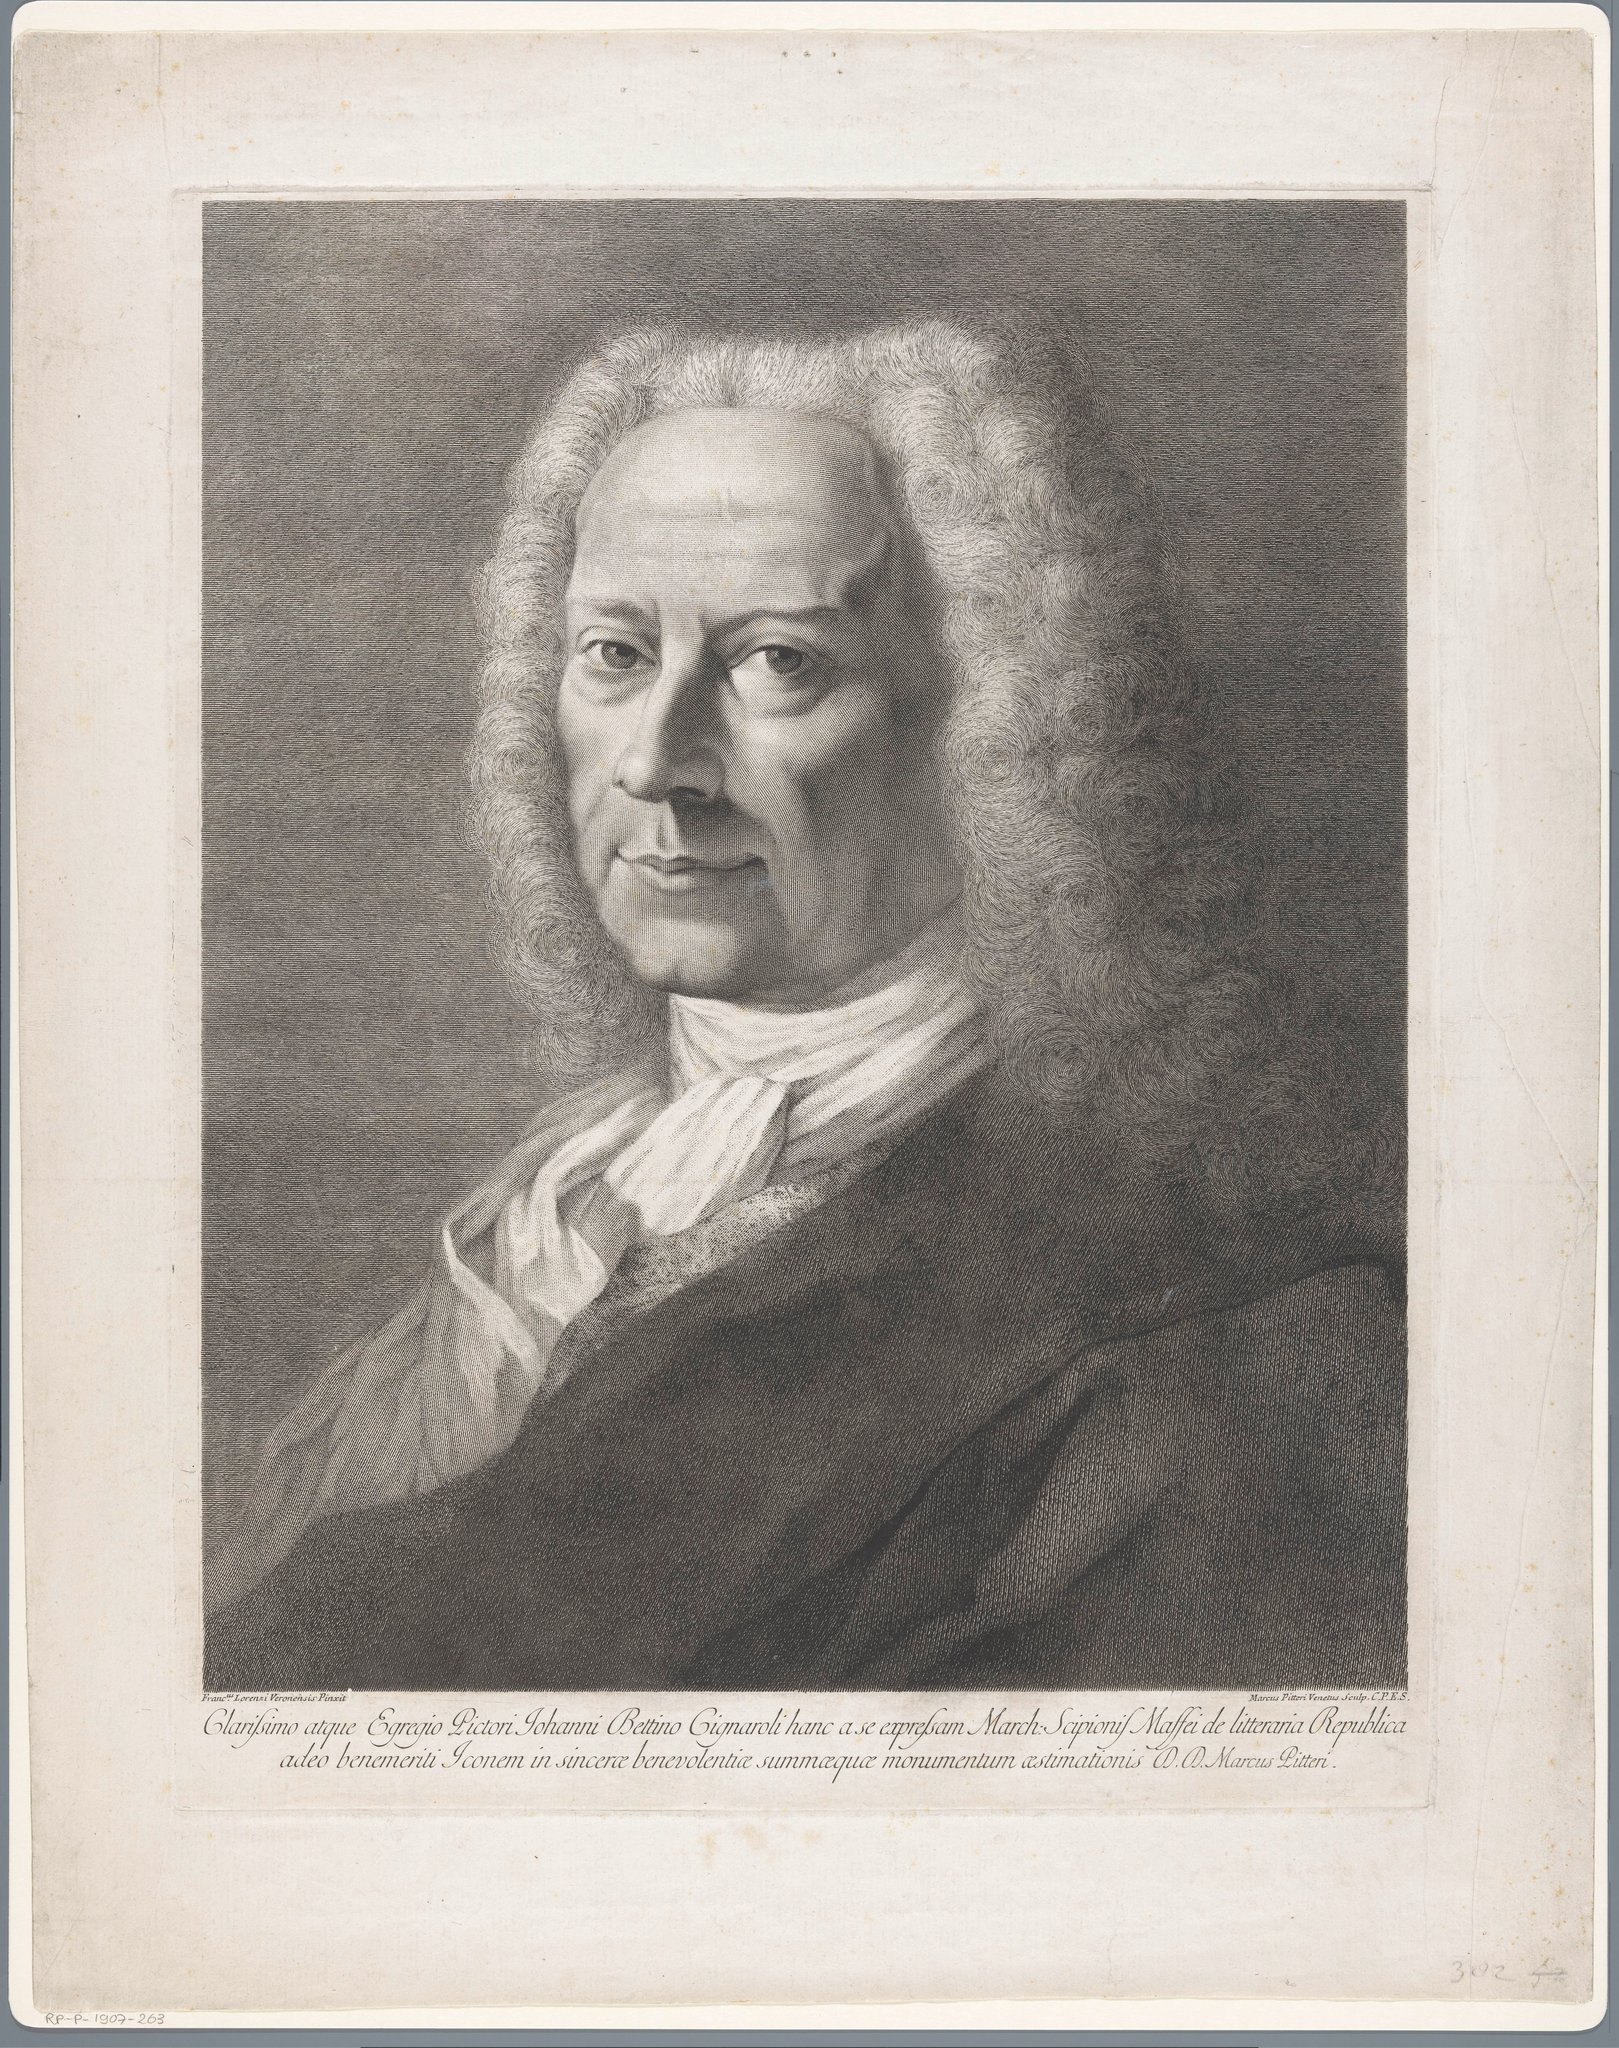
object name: print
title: Portret van schilder Giambettino Cignaroli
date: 1712-1786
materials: paper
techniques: engraving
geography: venice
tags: painter, giambettino cignaroli, historical persons, portrait, self-portrait of artist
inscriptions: collector's mark: Lugt 2228